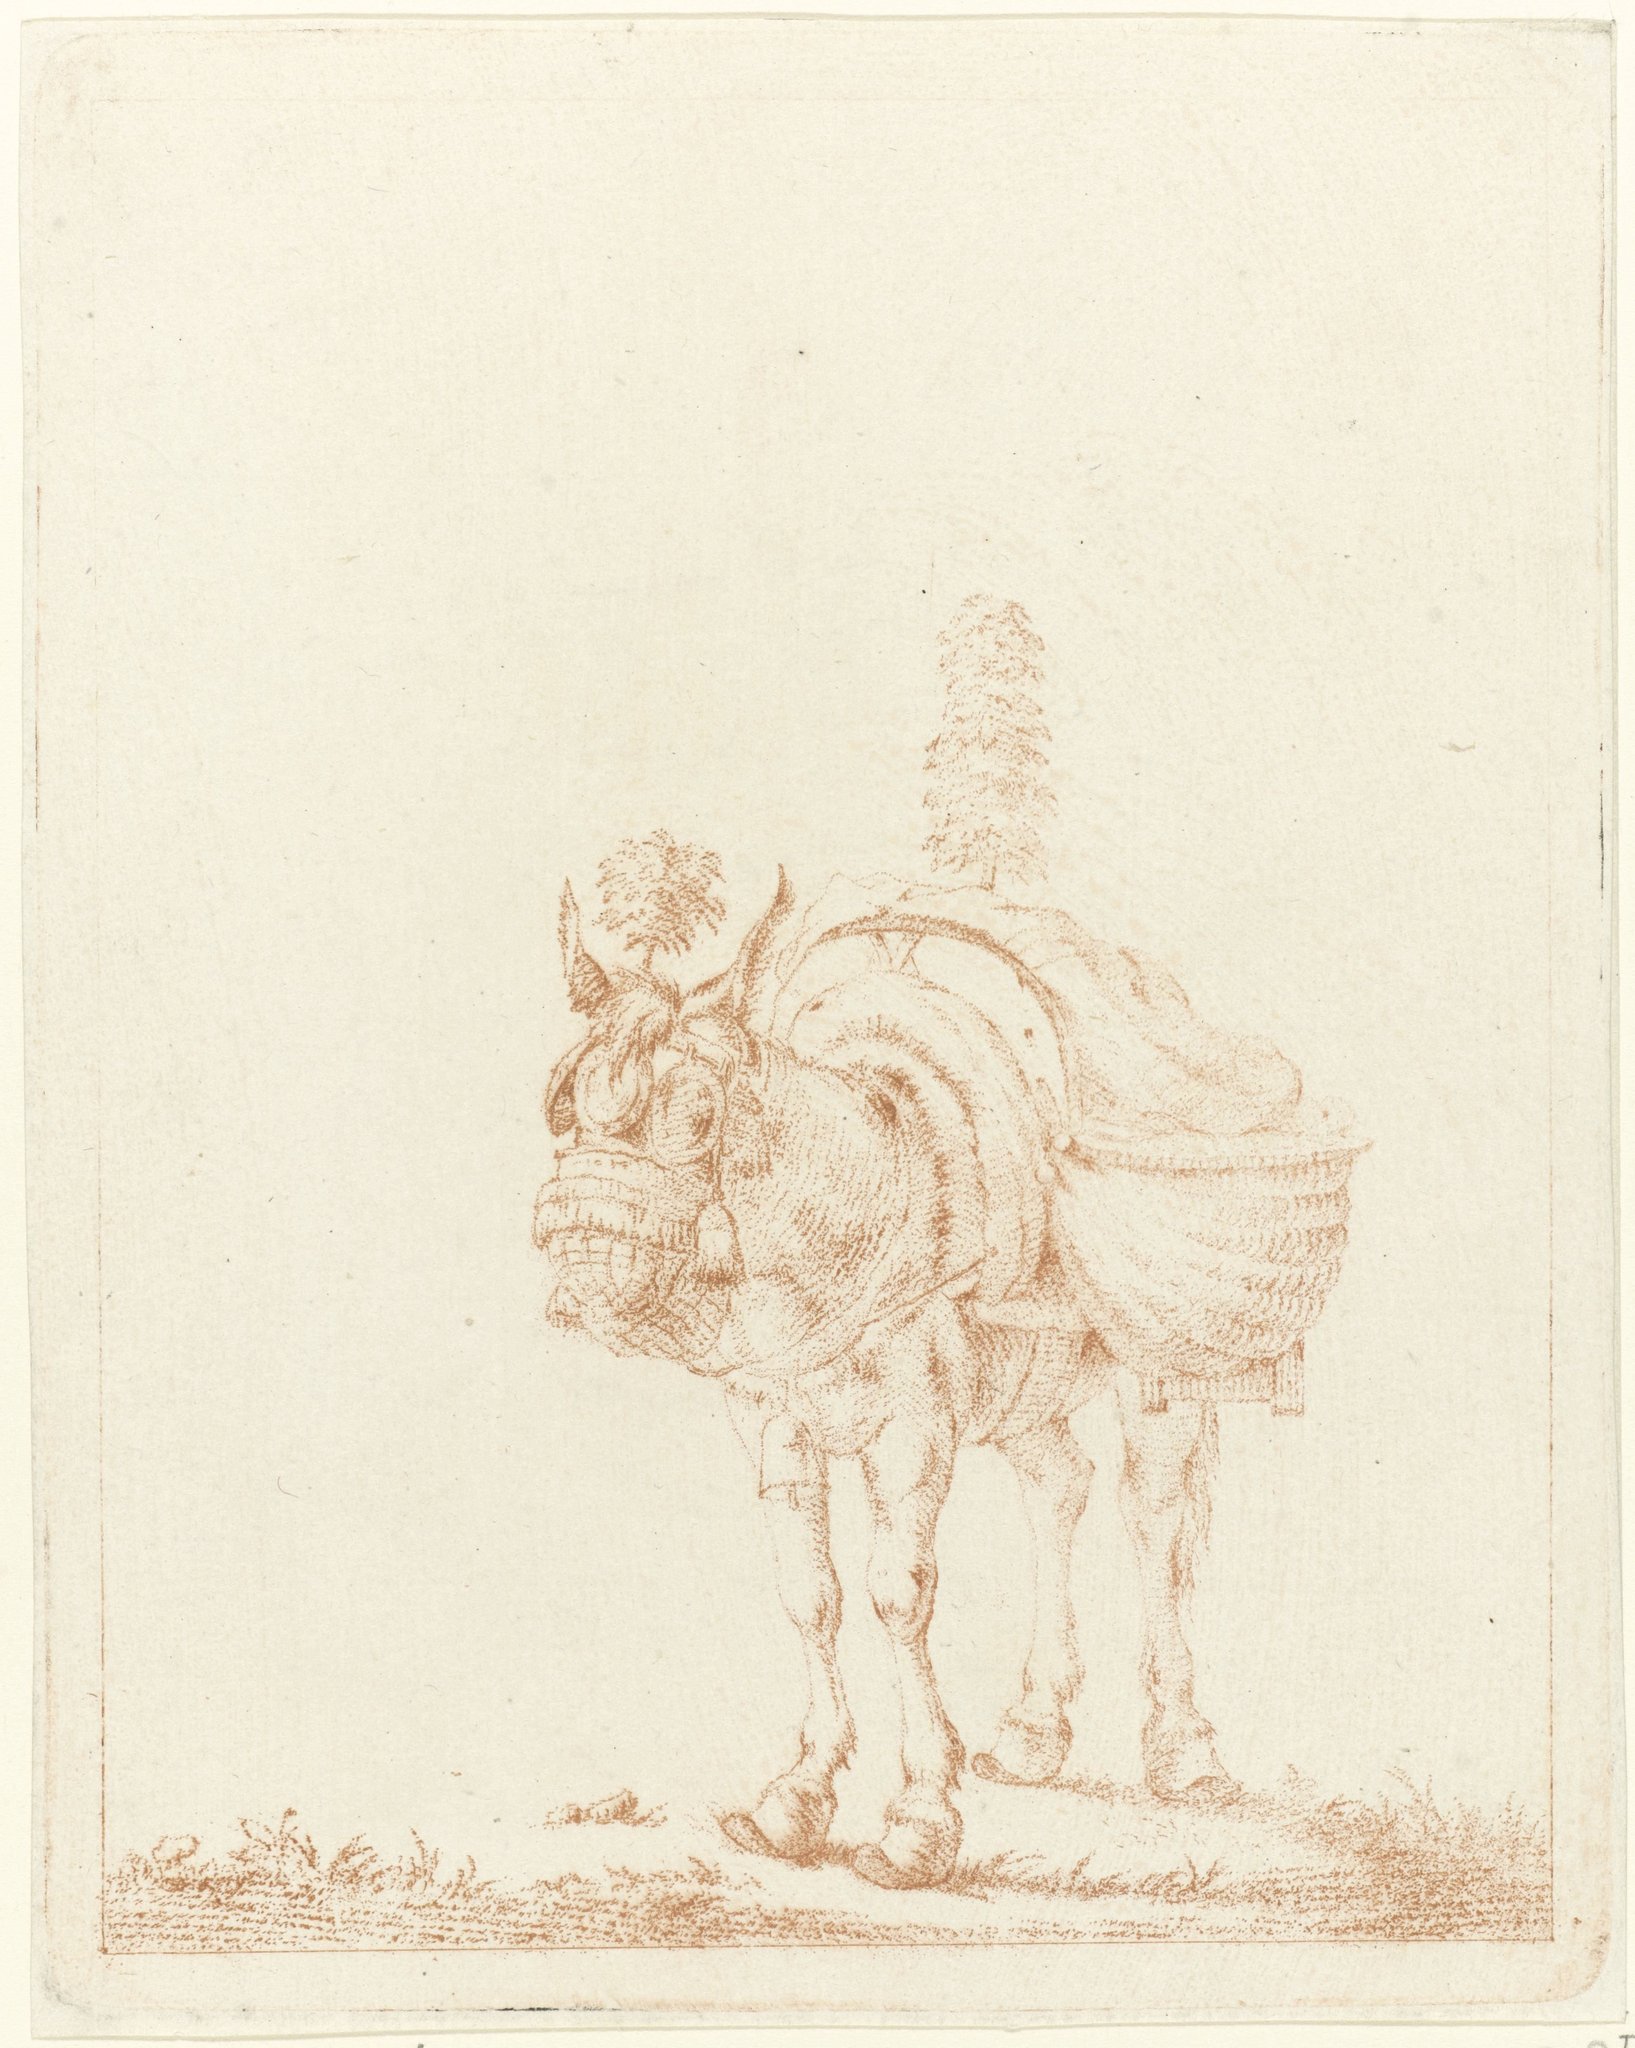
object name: print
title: Bepakte muilezel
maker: johannes janson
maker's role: draughtsman, painter, print maker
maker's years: 1729-1784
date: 1761-1784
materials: paper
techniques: etching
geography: leiden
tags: mule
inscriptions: collector's mark: Lugt 2228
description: Bepakte muilezel met pluimen op kop en rug.